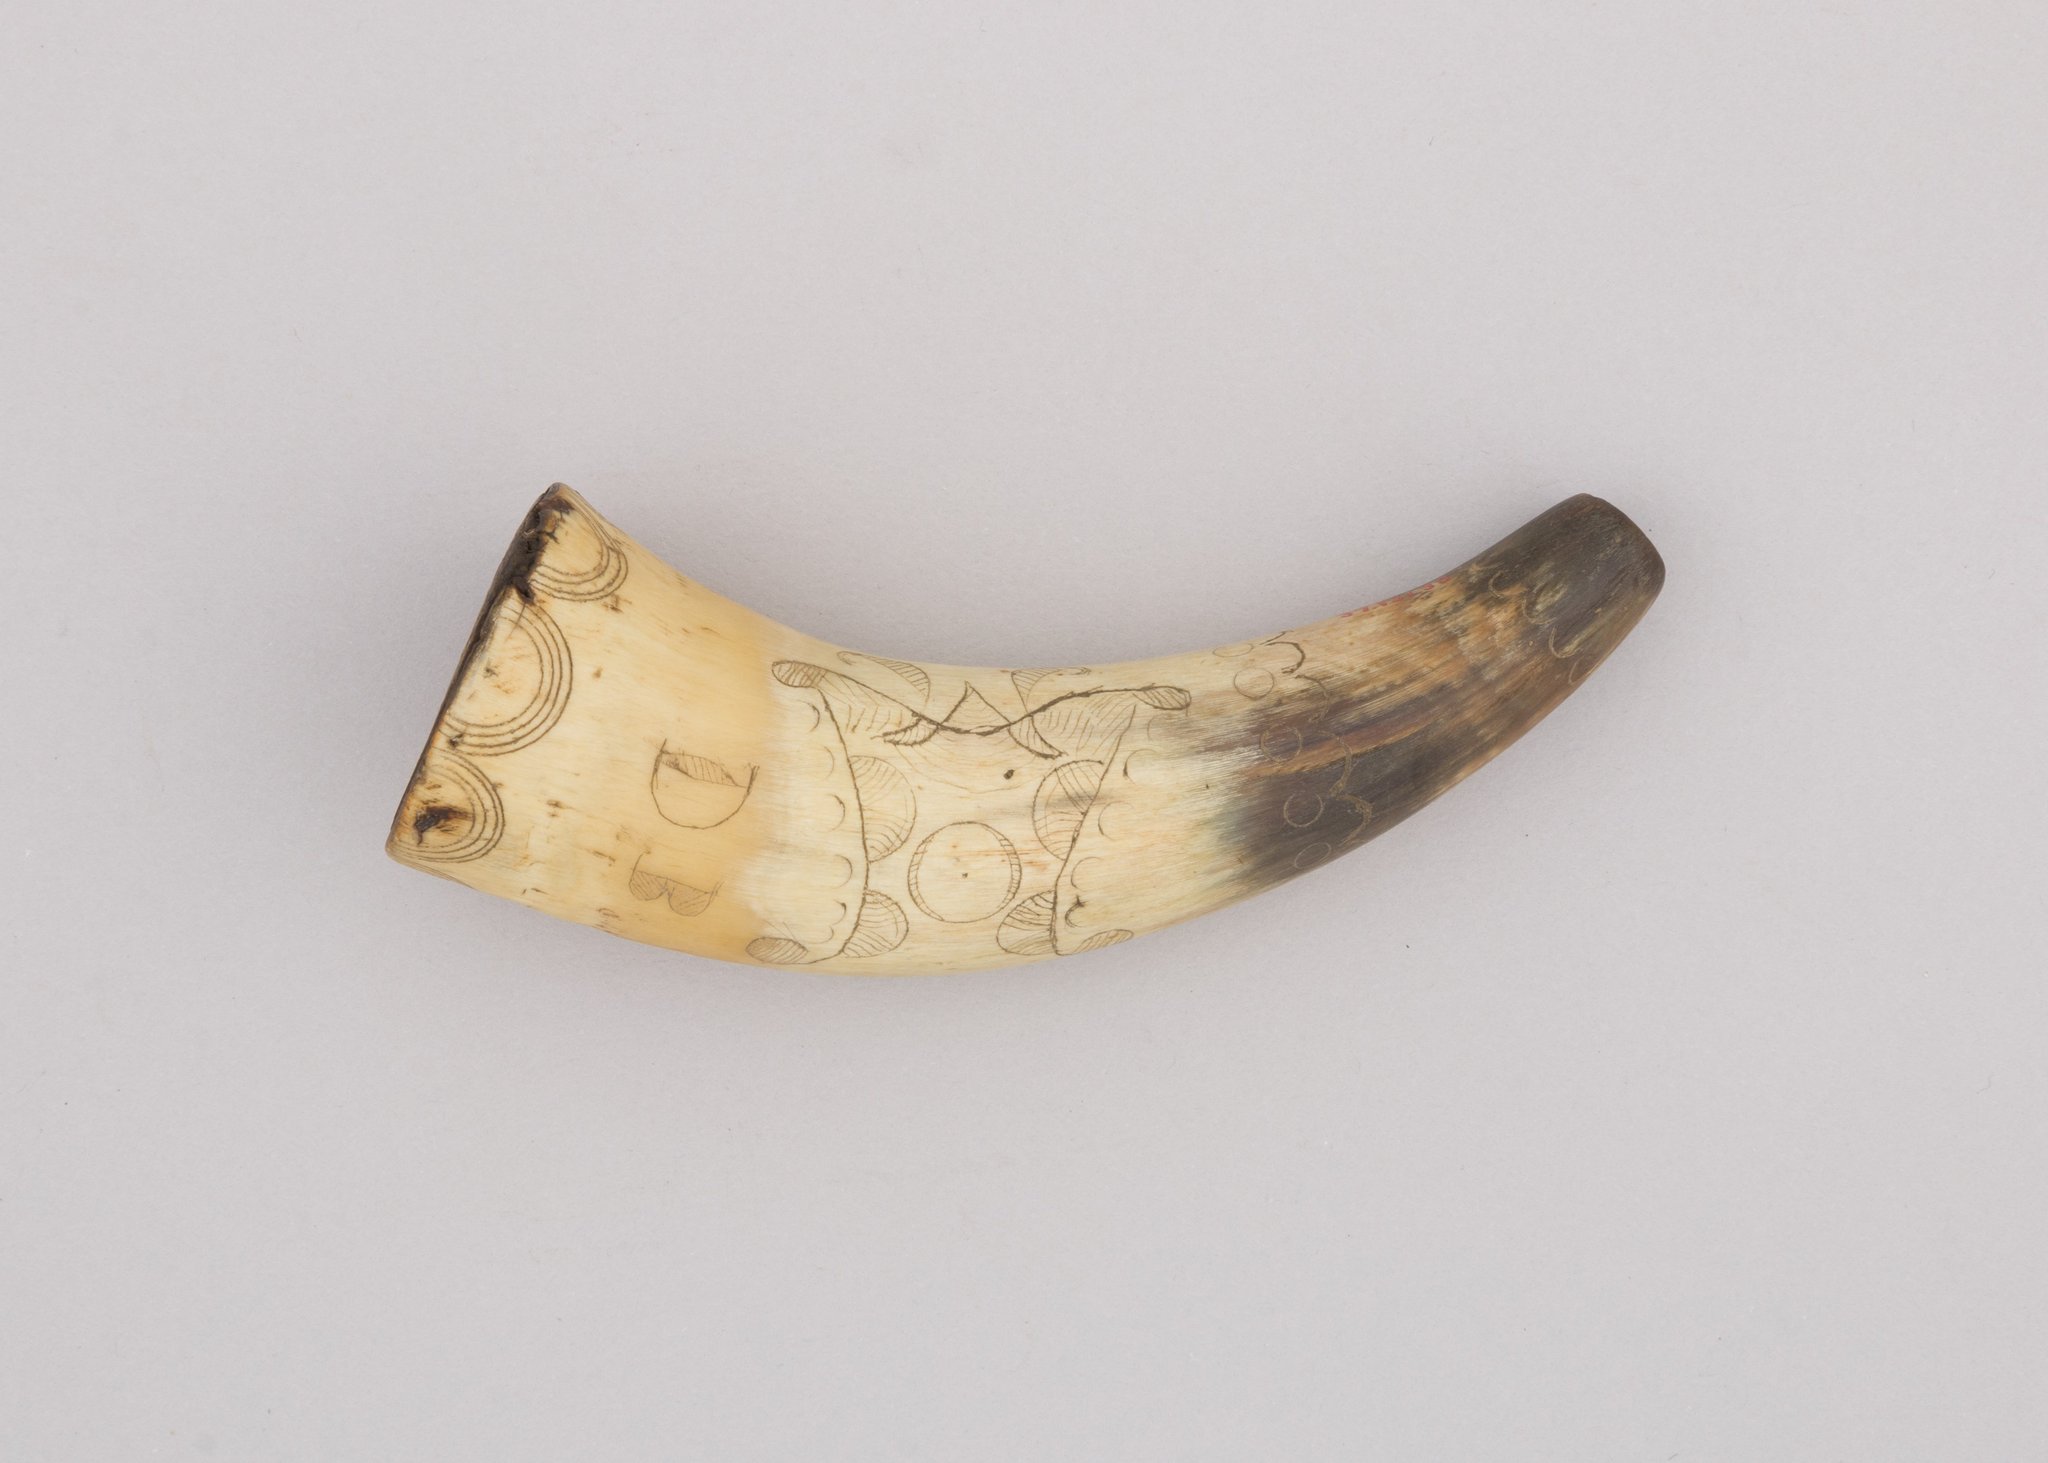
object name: powder horn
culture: american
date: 1801-1833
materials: horn, wood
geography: united states